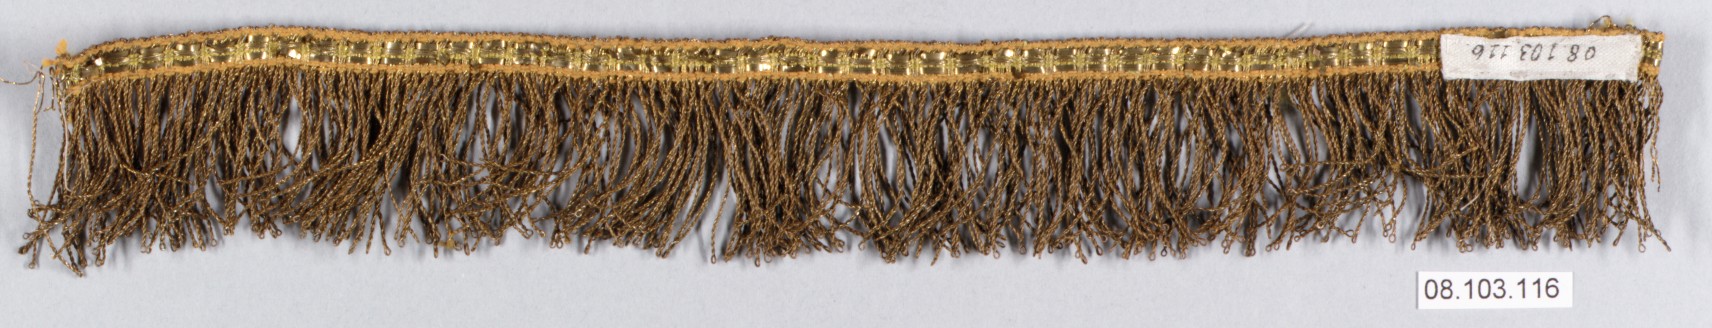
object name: fringe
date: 1801-1833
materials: cotton, metal thread